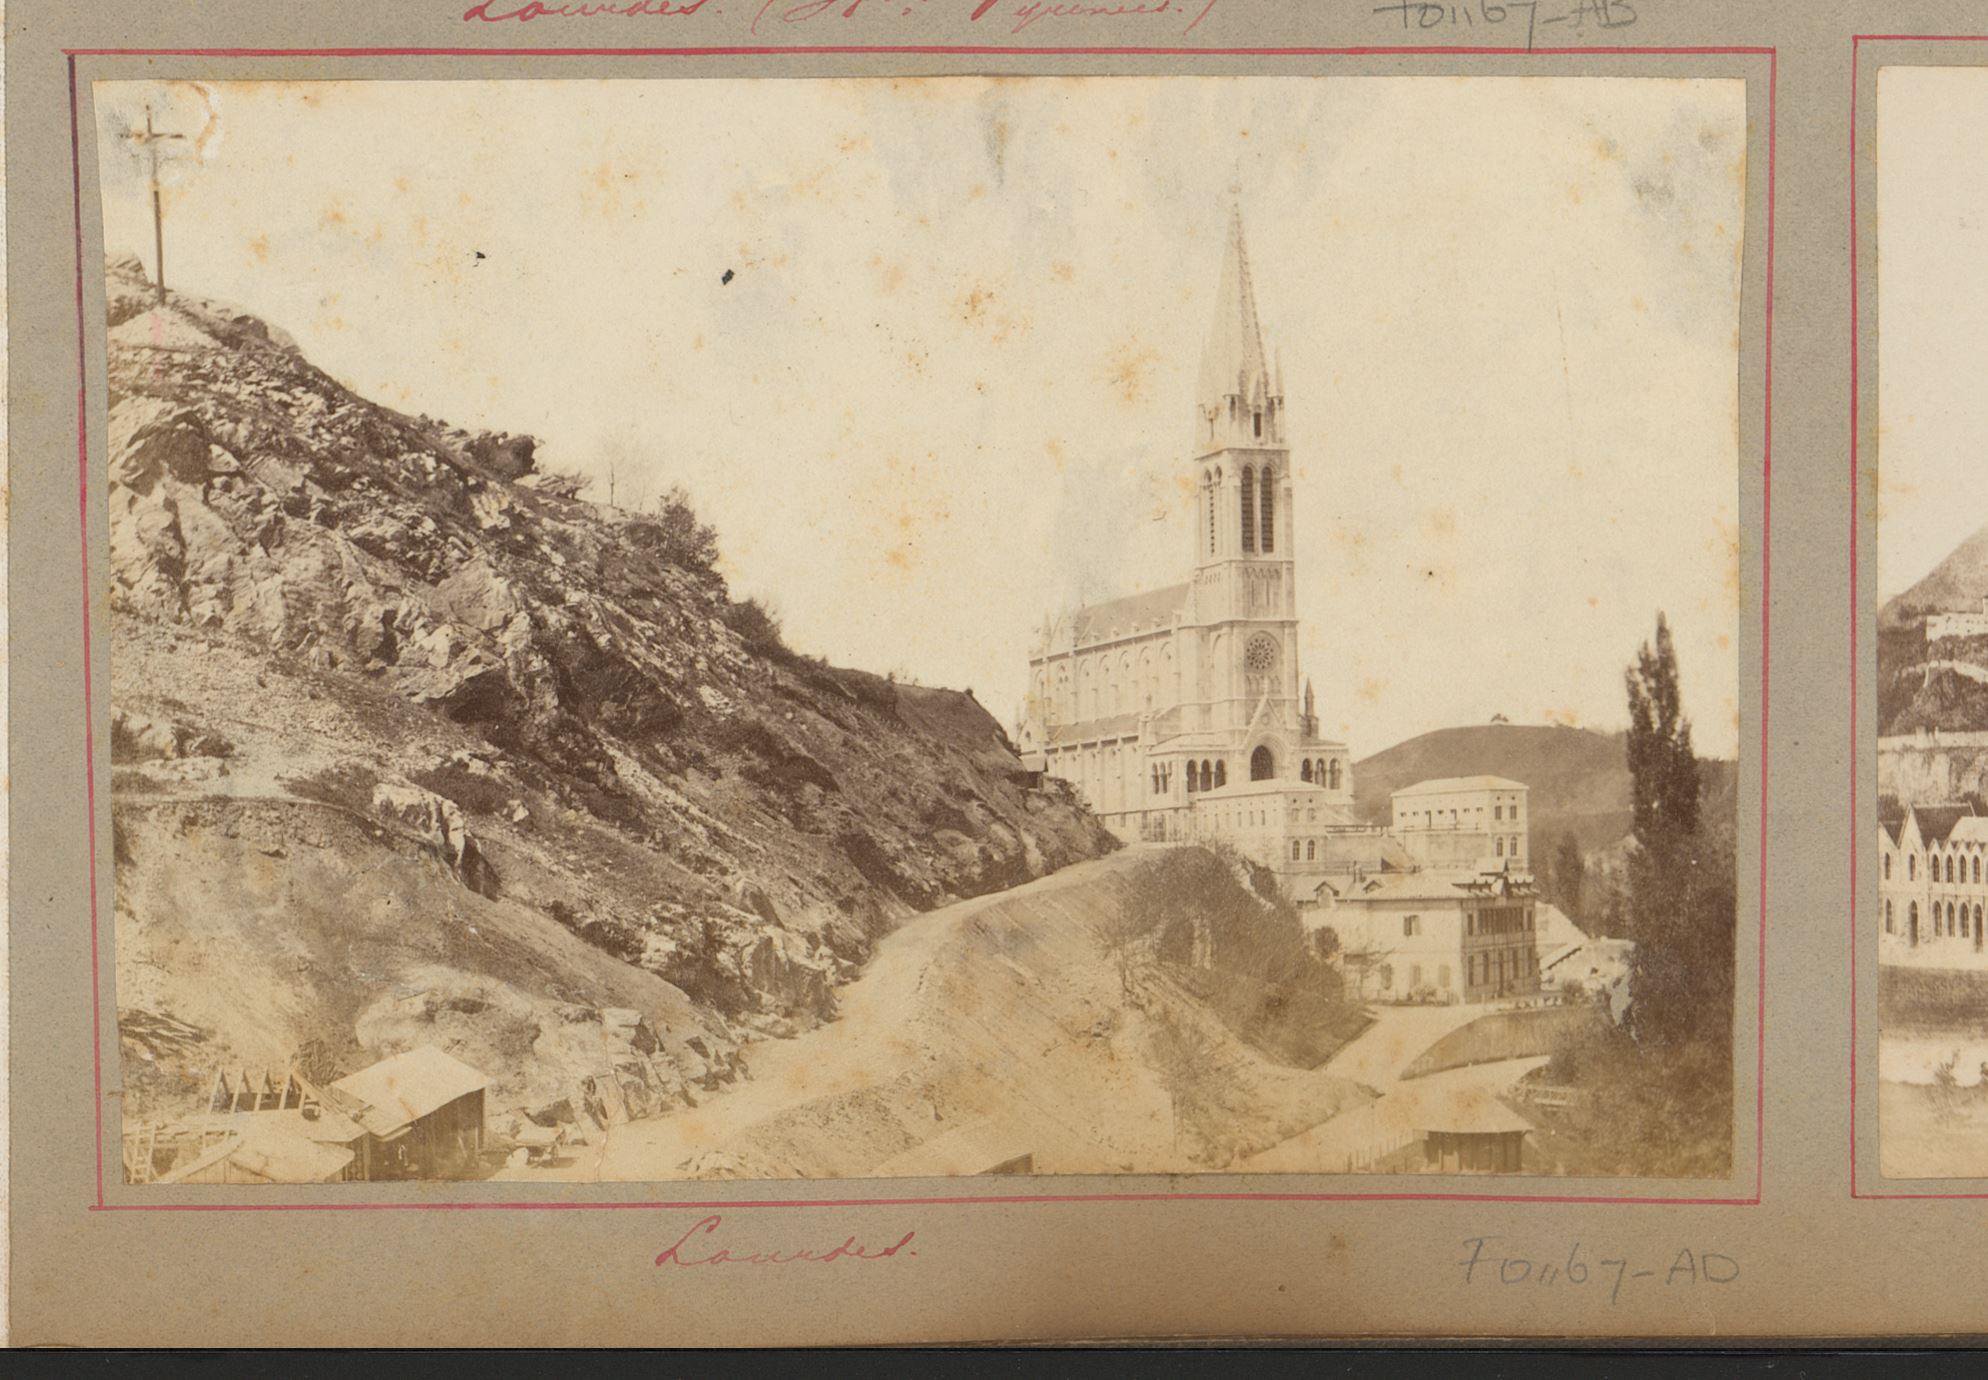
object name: album leaf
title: Gezicht op Lourdes met de Basiliek van de Onbevlekte Ontvangenis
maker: Anonymous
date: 1880-1910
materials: photographic support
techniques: albumen print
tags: city-view in general; 'veduta', church (exterior)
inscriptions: annotation: ‘Lourdes’